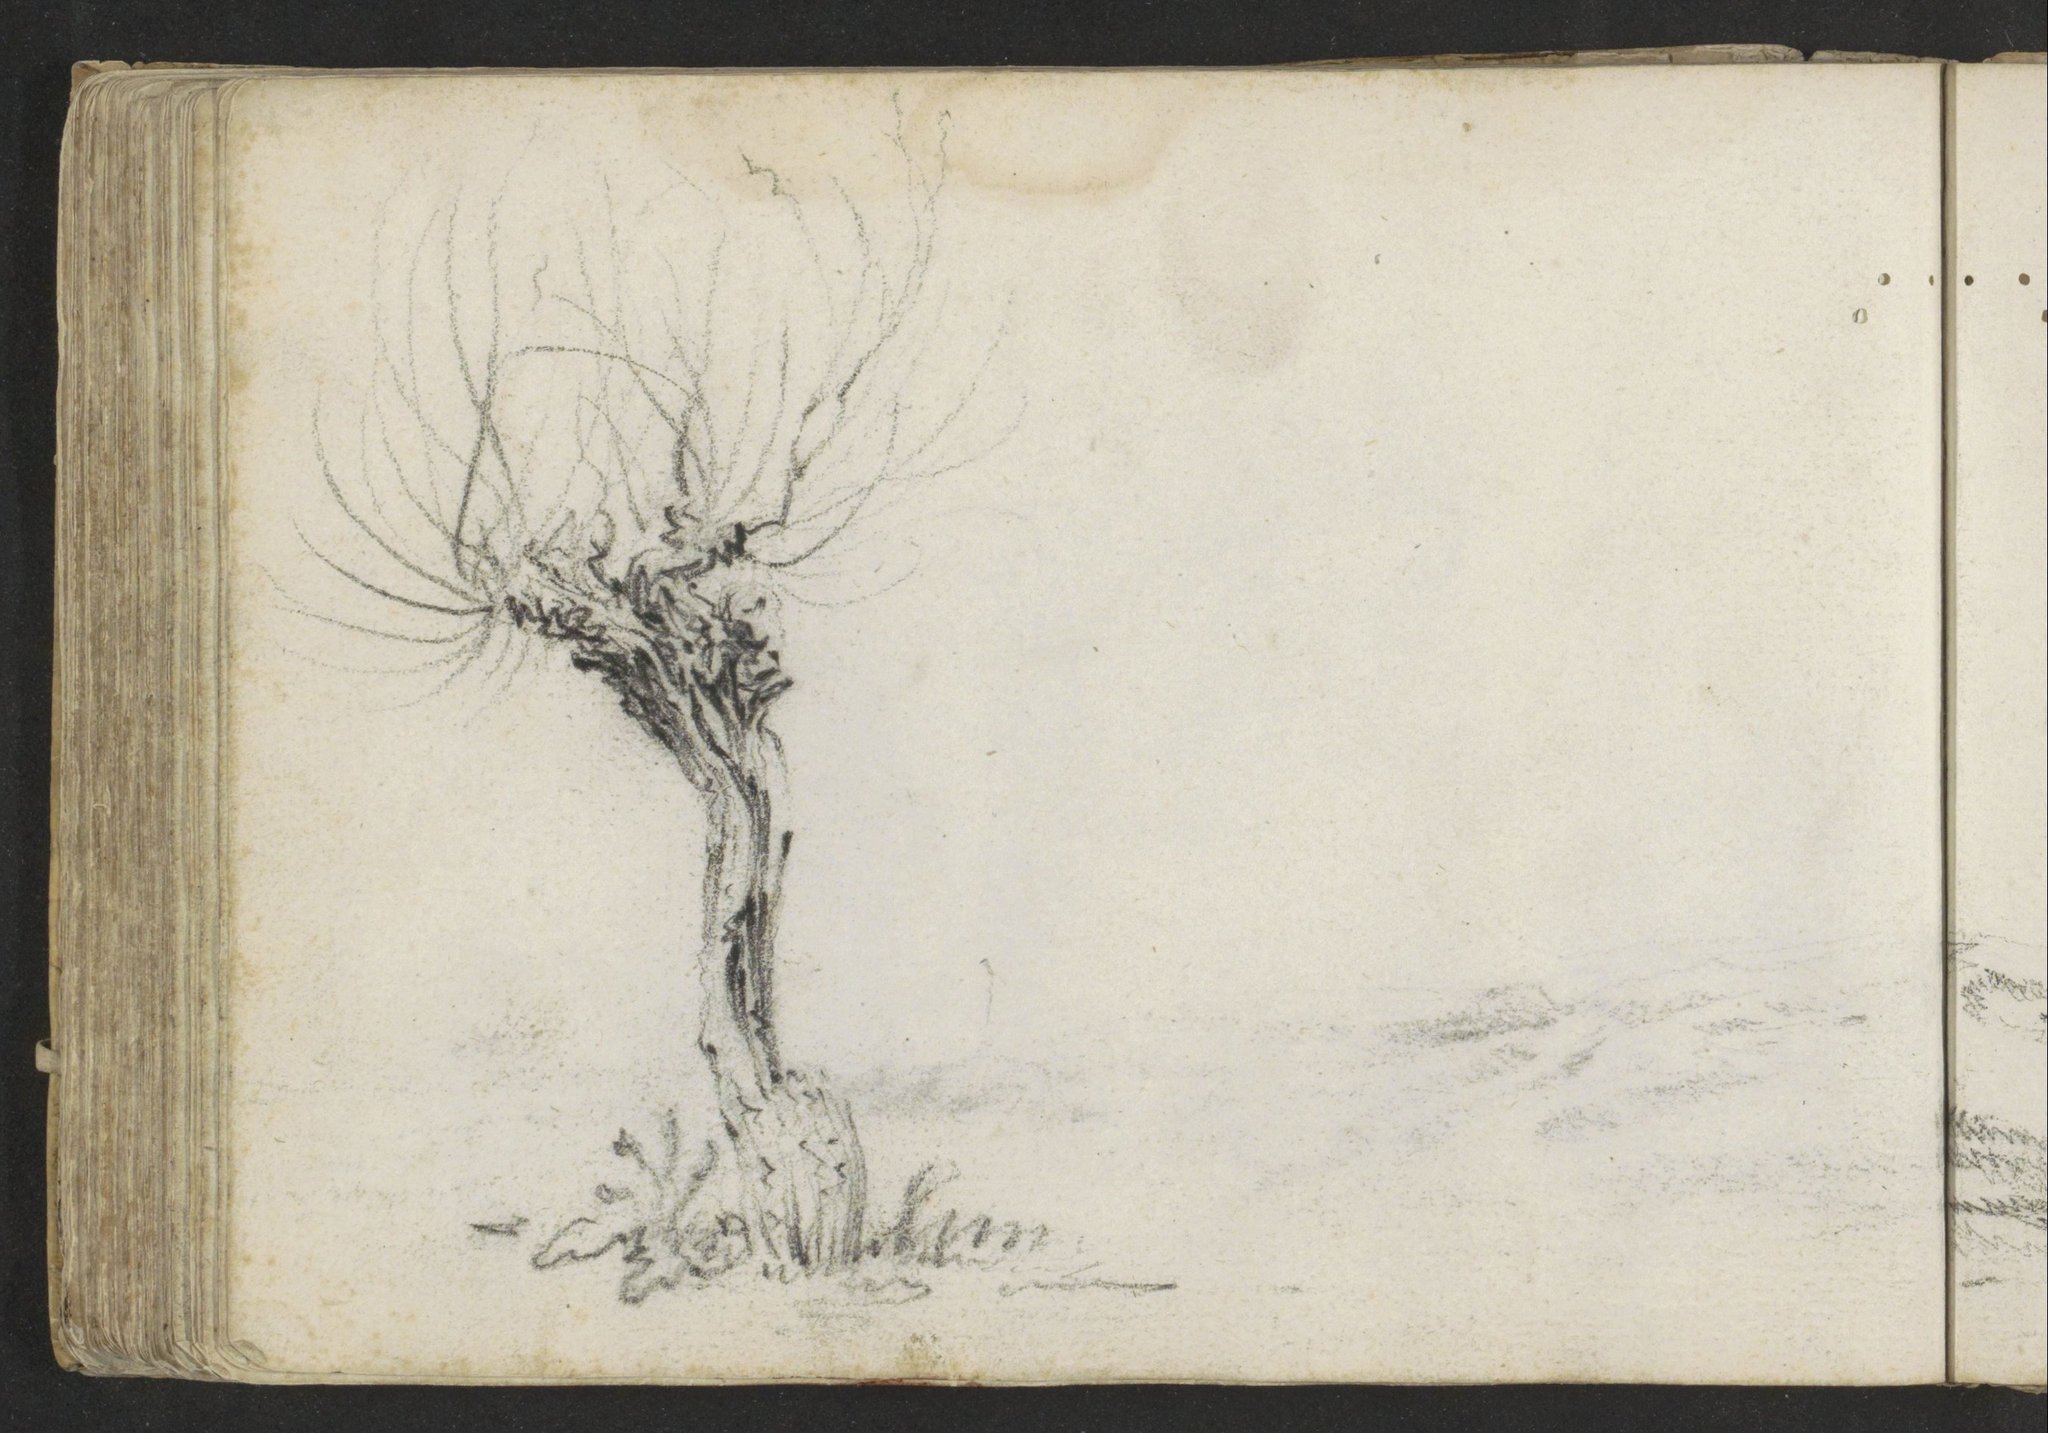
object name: sketchbook leaf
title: Knotwilg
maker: gerard ter borch (ii)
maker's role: draughtsman, painter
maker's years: 1617-1681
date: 1634-1635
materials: chalk, paper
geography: haarlem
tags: trees: willow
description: Blad 54 verso uit een schetsboek met 55 bladen.